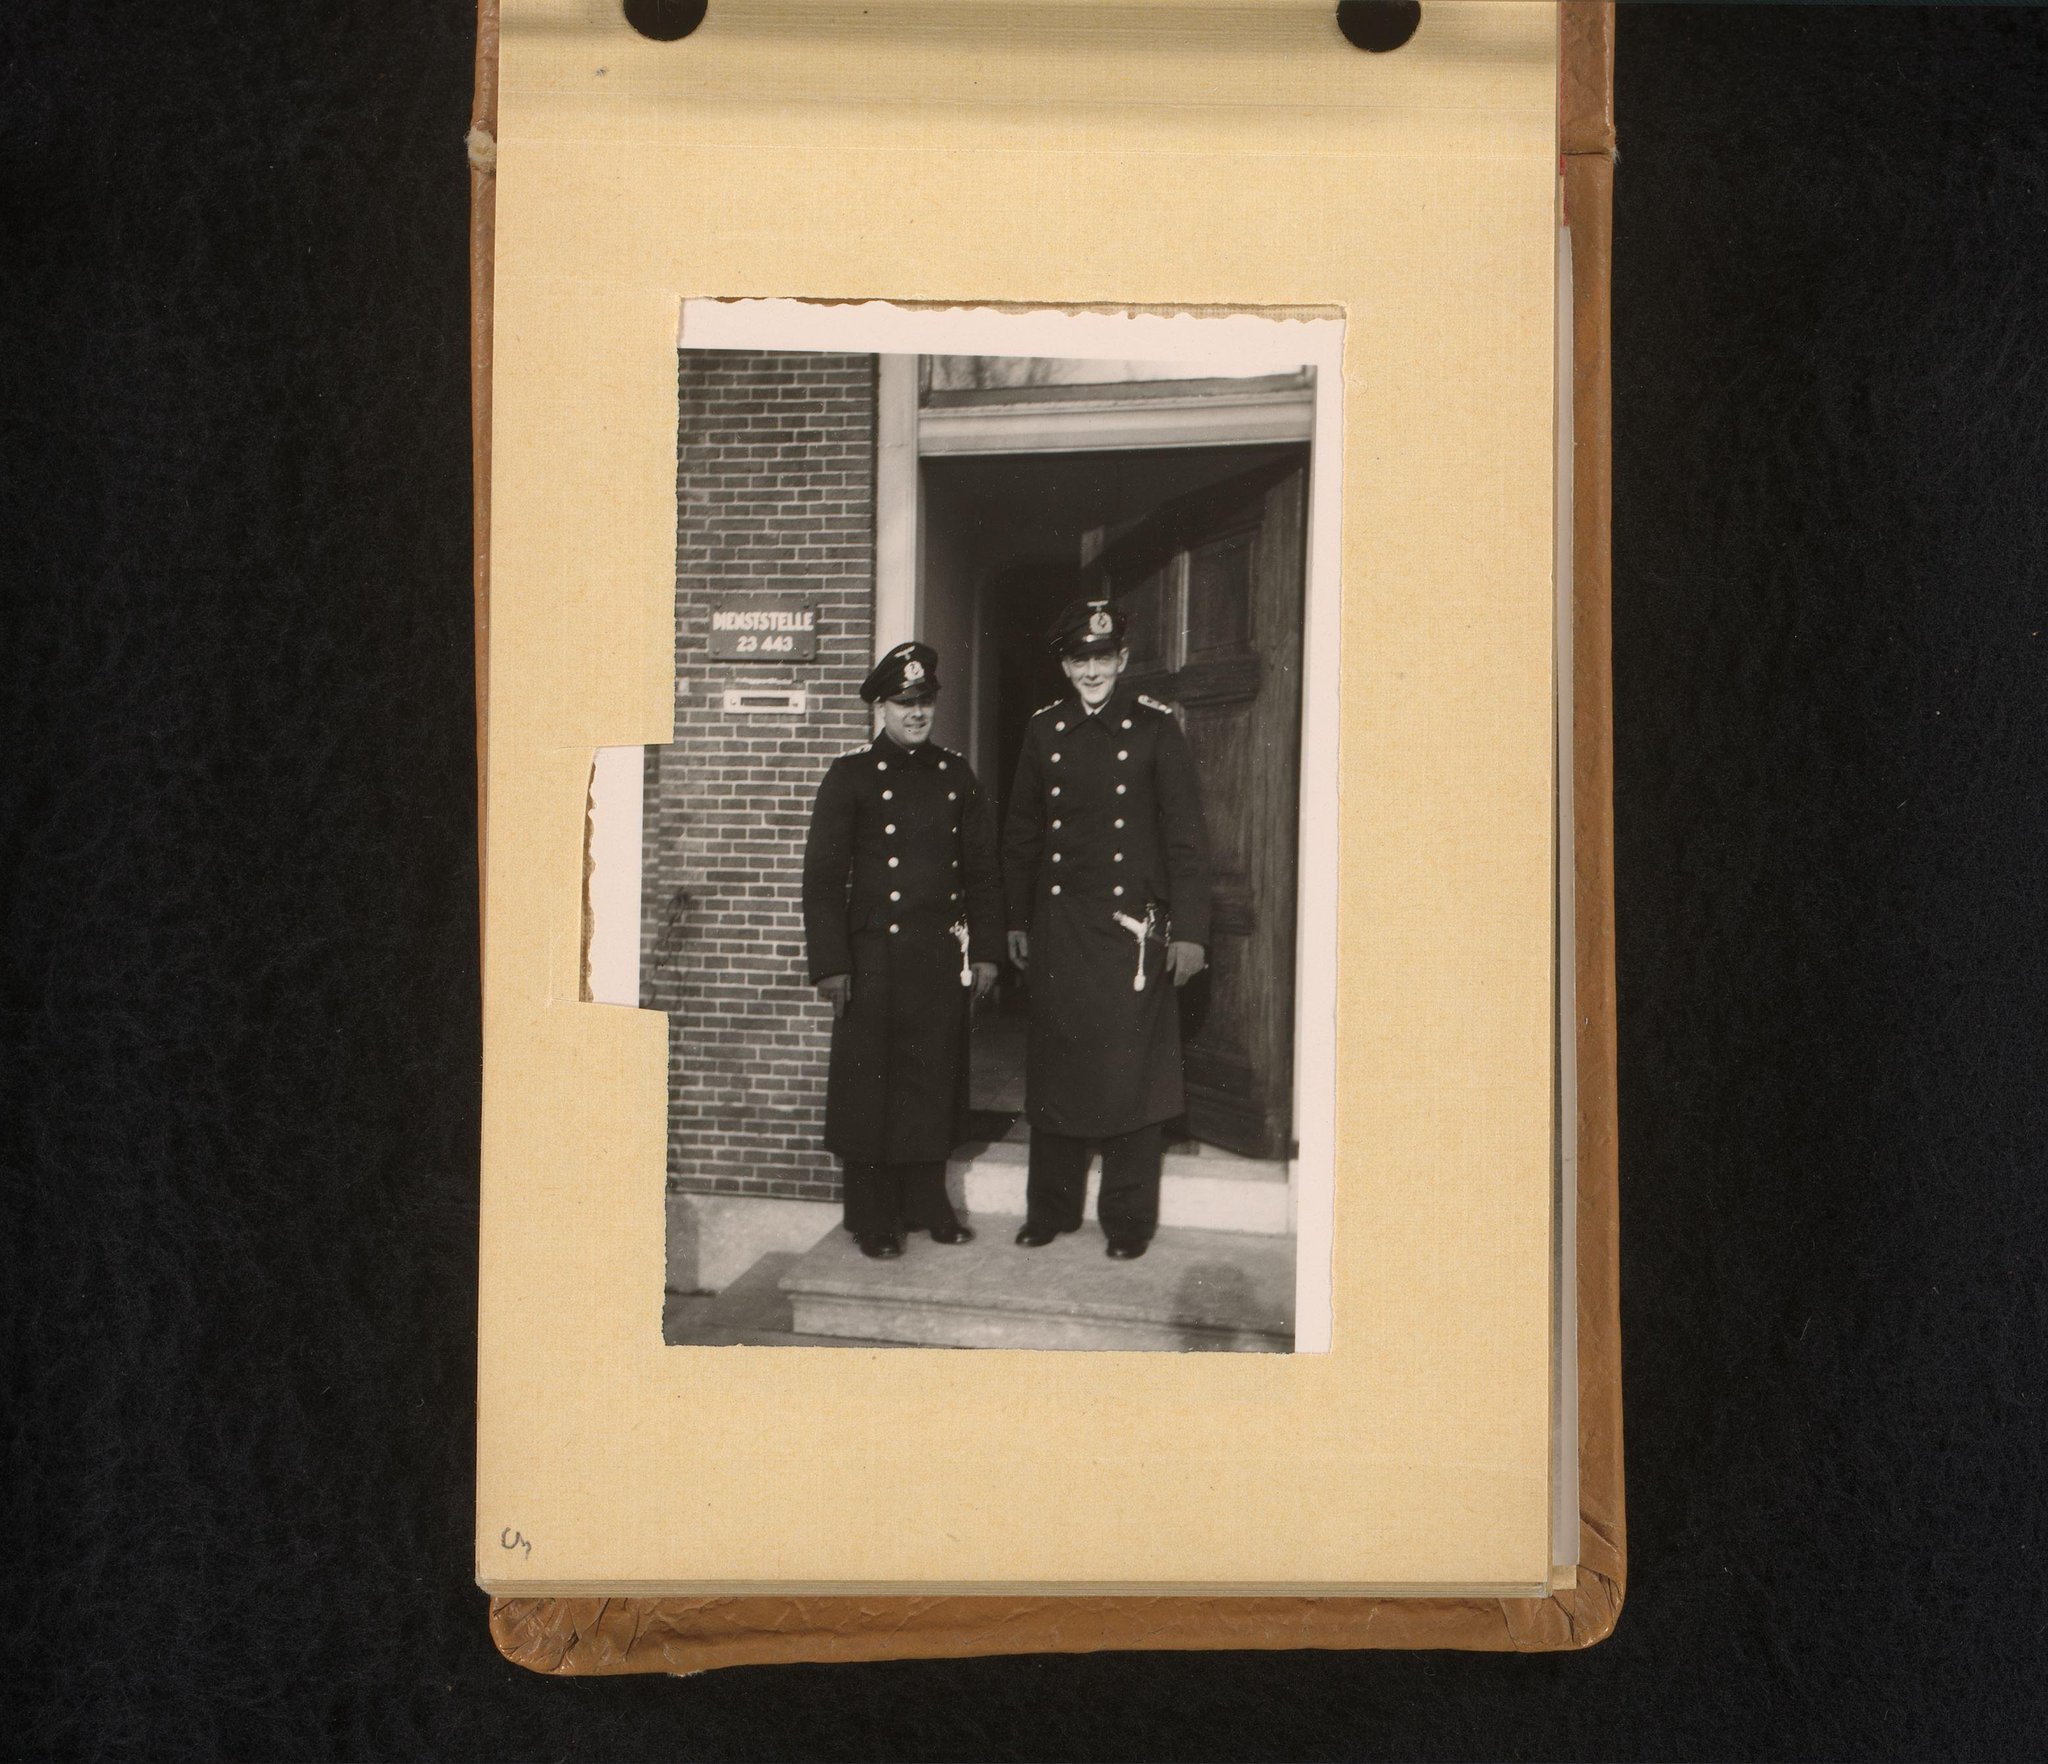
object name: album leaf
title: Staande militairen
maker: Anonymous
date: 1940-1943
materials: paper, photographic support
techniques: gelatin silver print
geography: netherlands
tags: the company, the unit, the troop ~ military service, shelter ~ military service, occupation ~ war, netherlands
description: Albumblad met een foto van twee militairen staande in de deuropening van het onderkomen van de Kriegsmarine in Nederland: Dienststelle 23 443. Onderdeel van een klein album van de Kriegsmarine in Nederland.